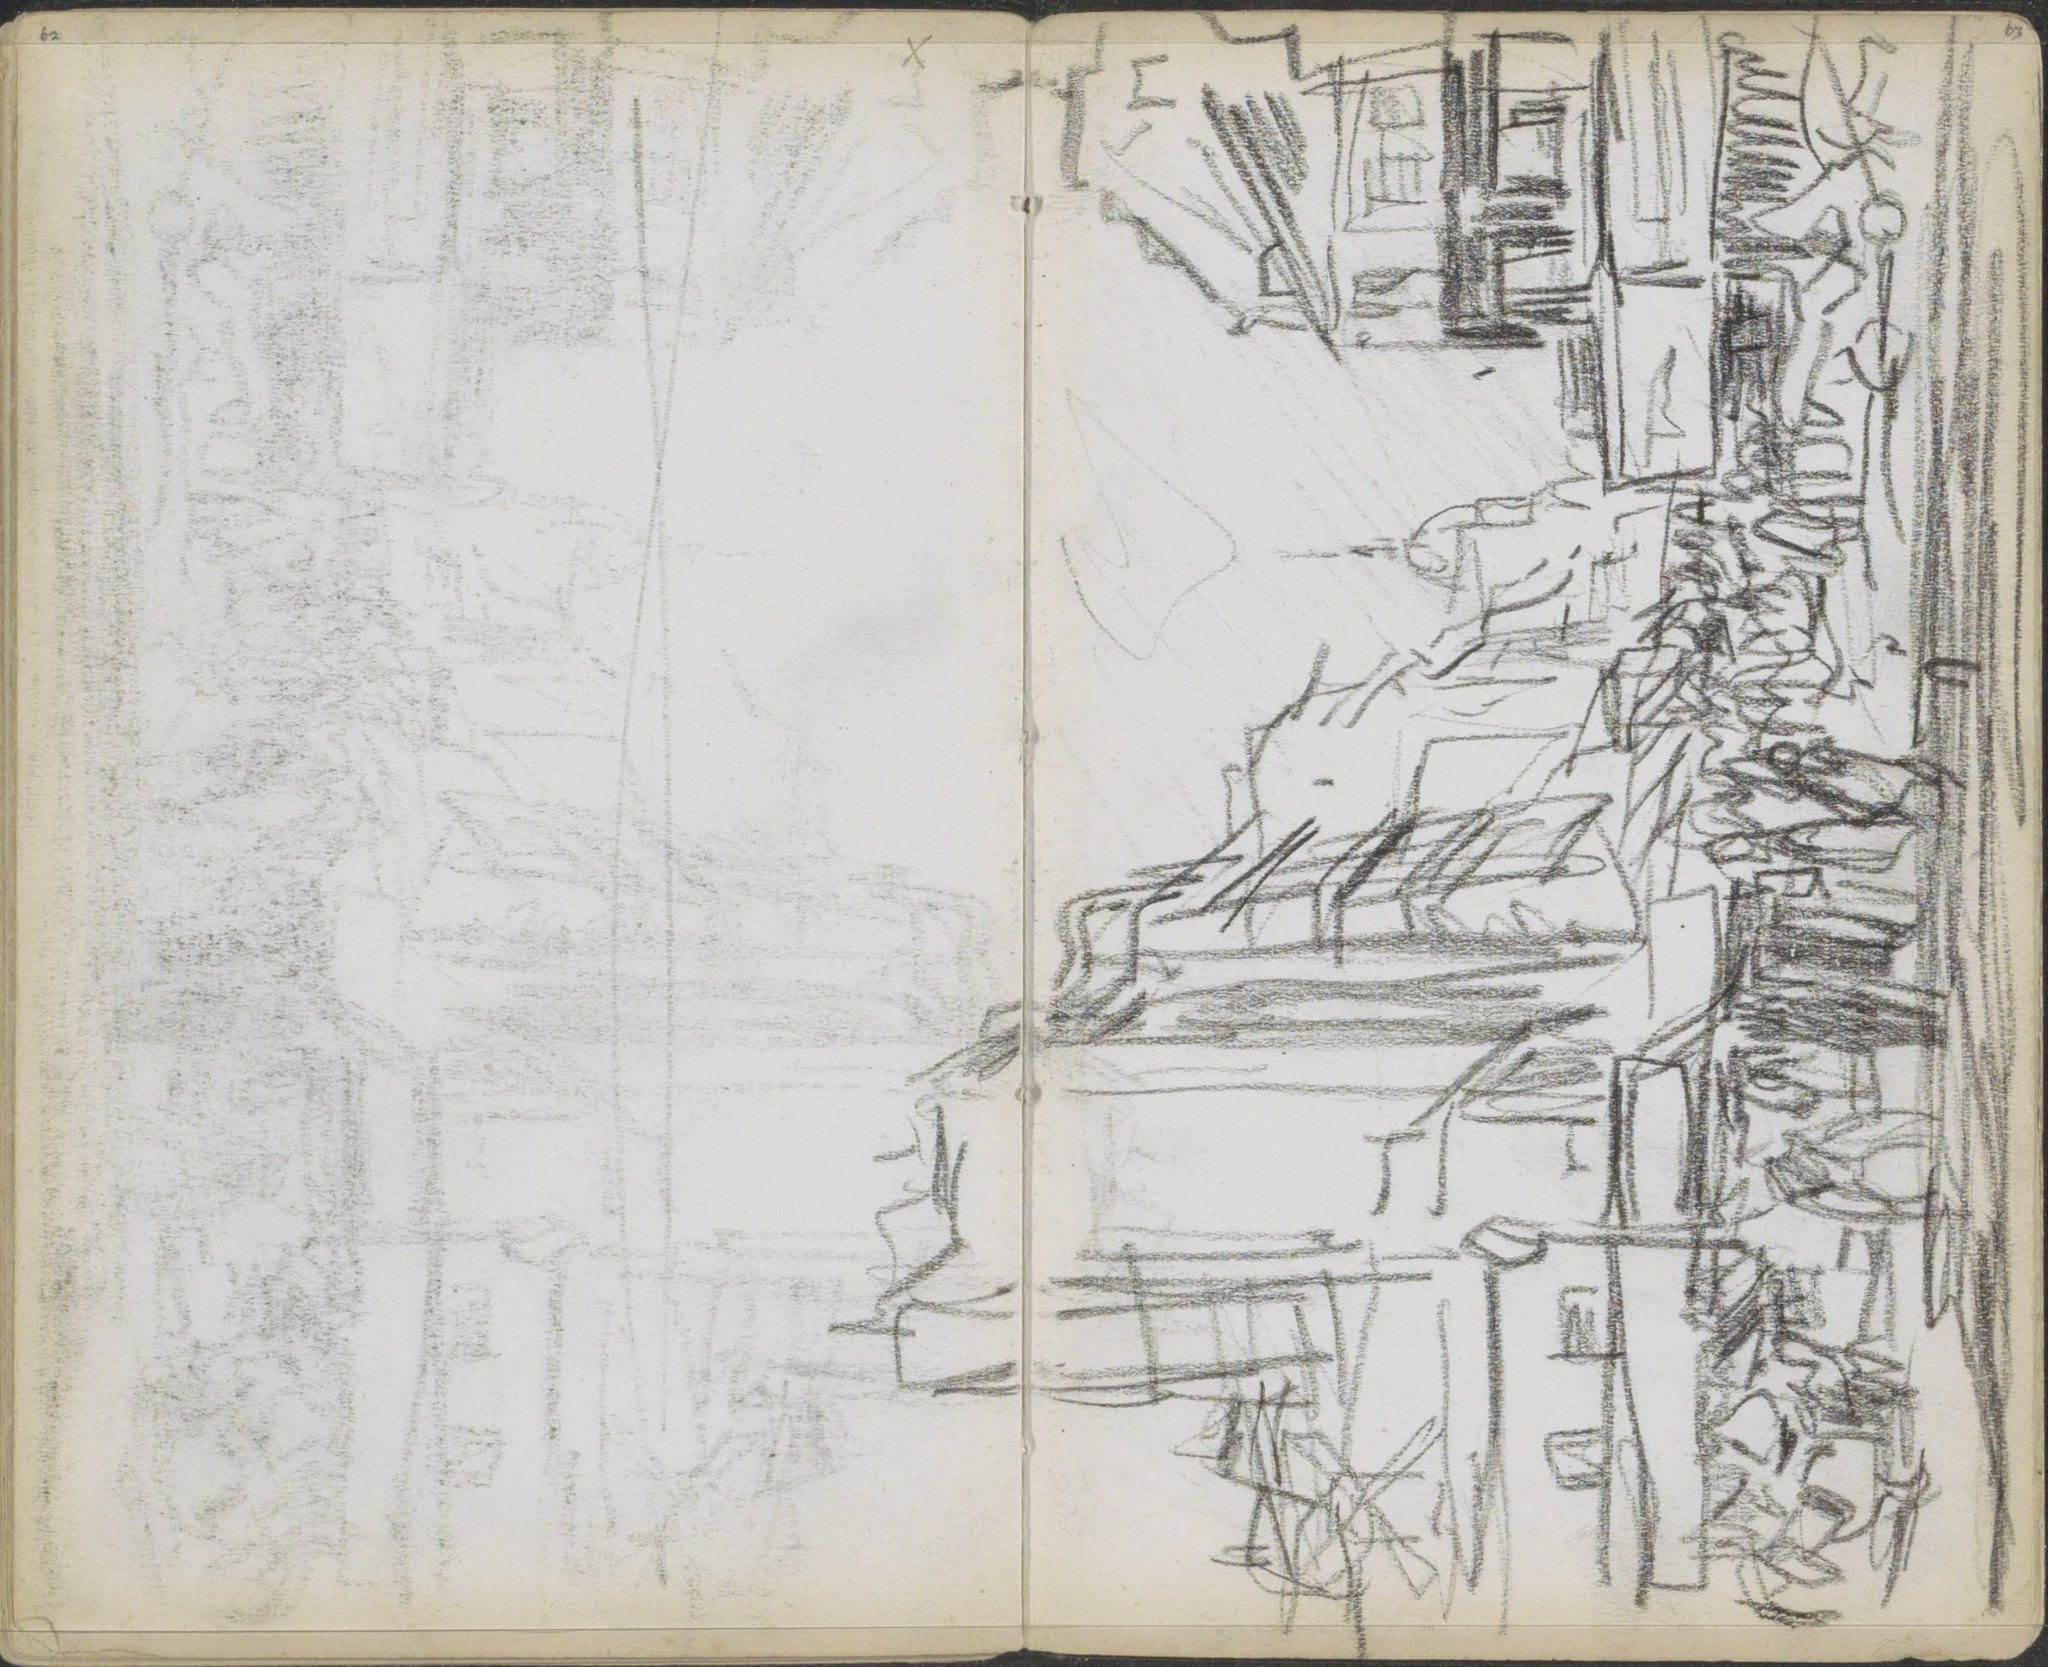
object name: sketchbook leaf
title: Straat in Parijs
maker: marius bauer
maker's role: draughtsman, print maker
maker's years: 1867-1932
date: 1810-1891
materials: chalk, paper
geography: paris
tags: street (+ city(-scape) with figures, staffage), paris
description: Pagina 62 en 63 uit een schetsboek met 35 bladen.